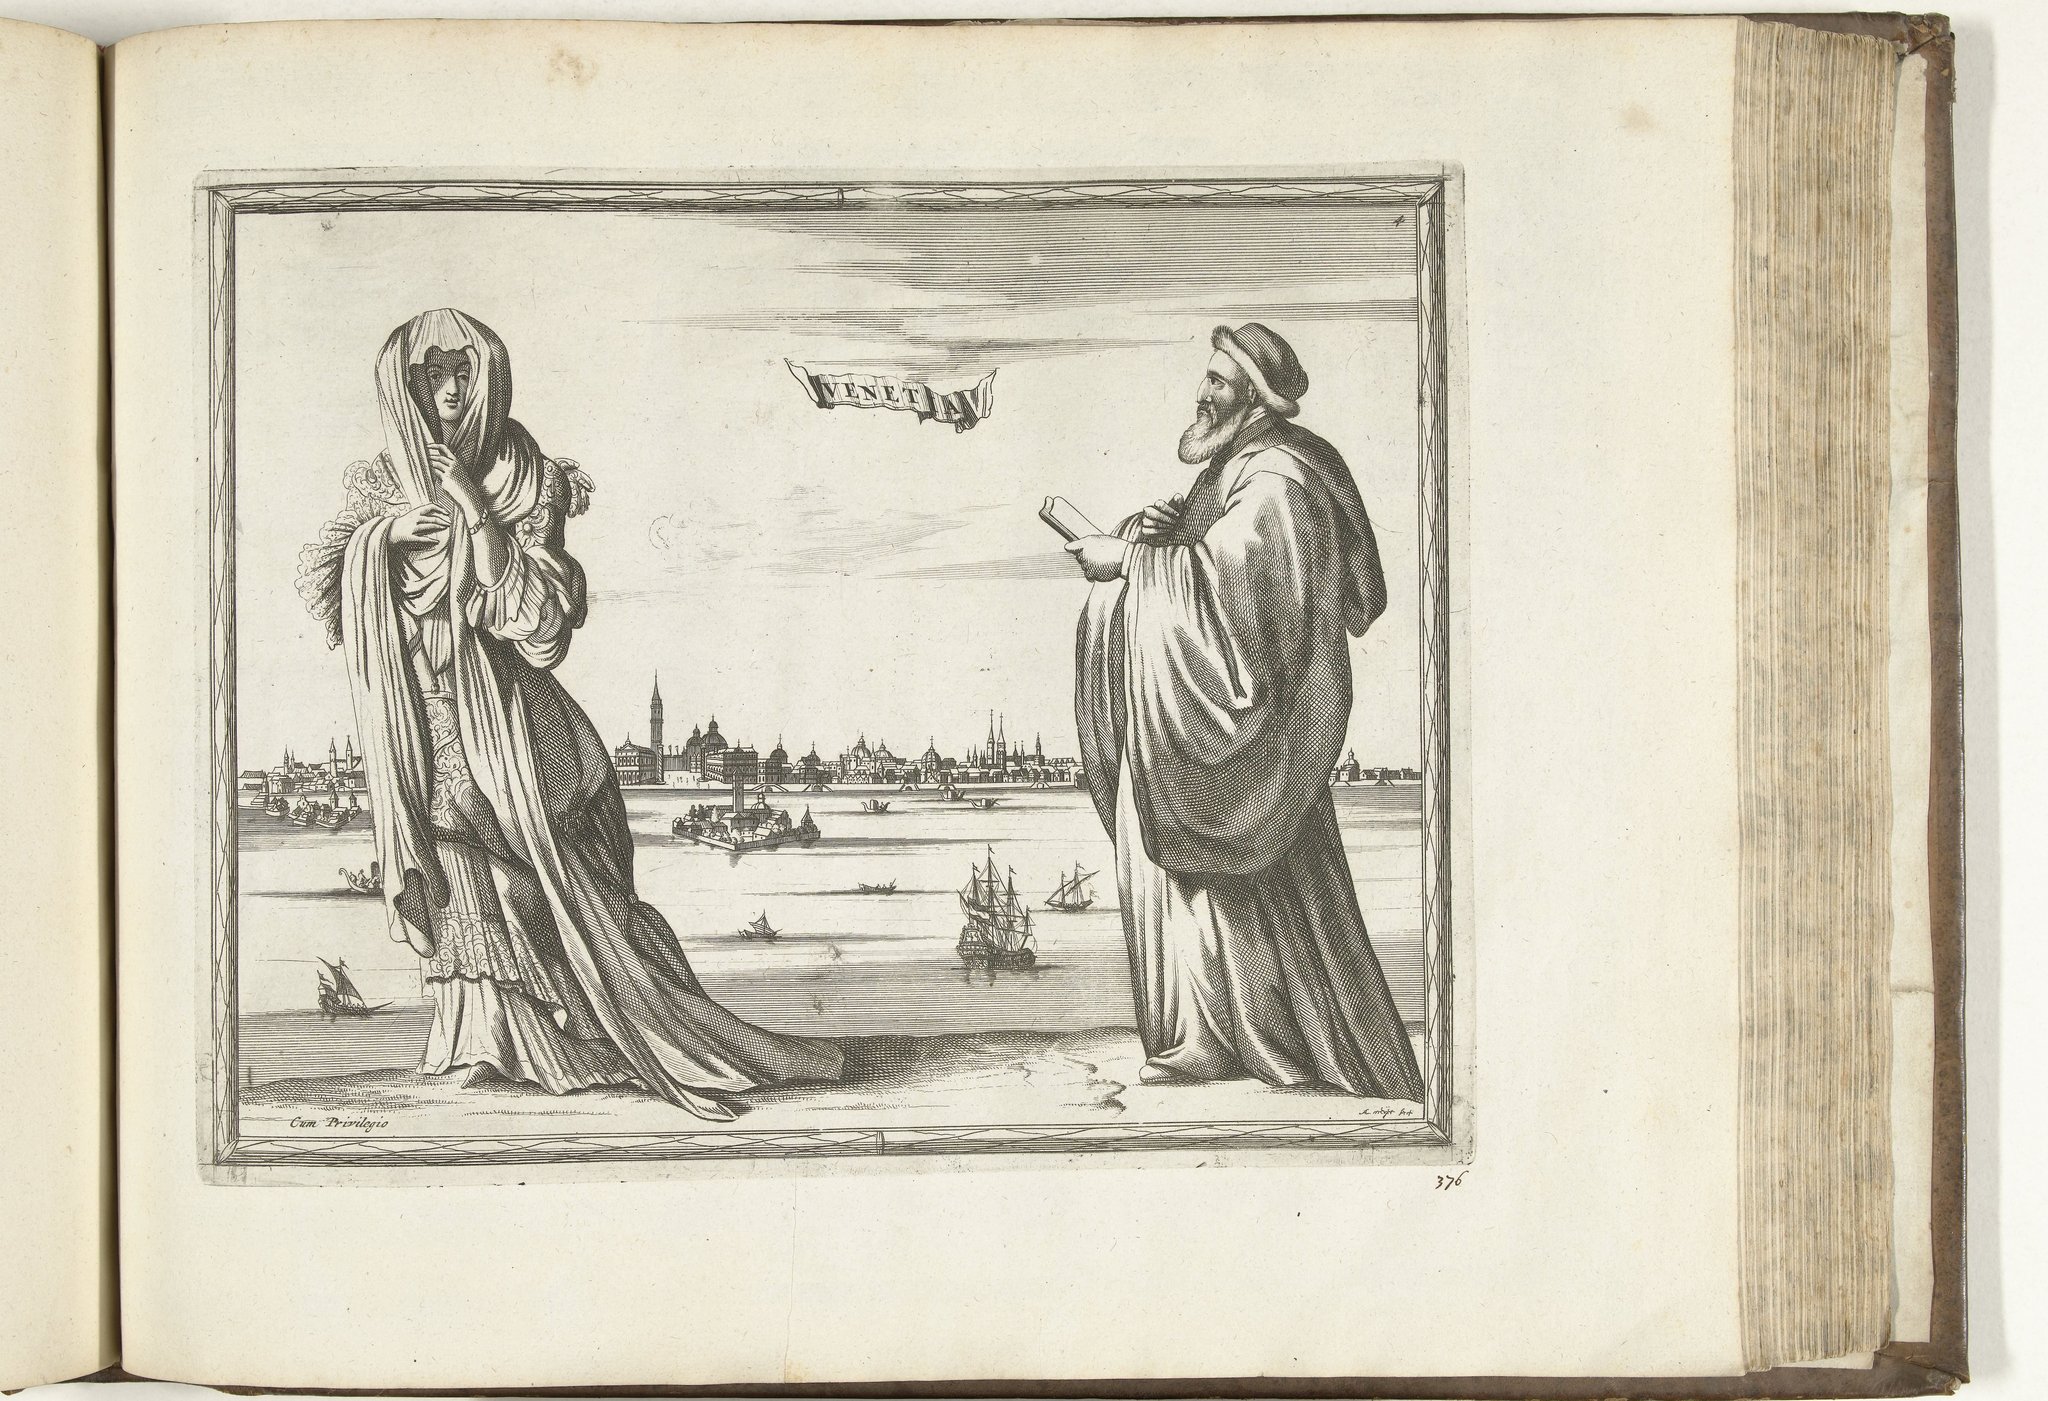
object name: print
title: Venetia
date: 1726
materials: paper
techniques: engraving, etching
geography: leiden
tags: folk costume, regional costume, venice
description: Twee inwoners van Venetië, een vrouw en een man in kostuum typerend voor de stad, op de achtergrond het profiel van Venetië. Plaat nr. 376 in deel XVI van het prentwerk: Les Forces de l'Europe, Asie, Afrique et Amerique ... Comme aussi les Cartes des Côtes de France et d'Espagne uit 1726, dit tweede deel met 271 met de hand genummerde platen van vermaarde sterke steden en vestingen in het kader van de Spaanse Successieoorlog 1701-1713. Voor het merendeel zijn deze platen gekopieerd naar de anonieme Franse platen van vermaarde sterke steden en vestingen: in Les forces de l'Europe en in: Le theatre de la guerre, dans les Pays-Bas, beide oorspronkelijk uitgegeven door Nicolas de Fer te Parijs (1693-1697) in het kader van de Negenjarige Oorlog.